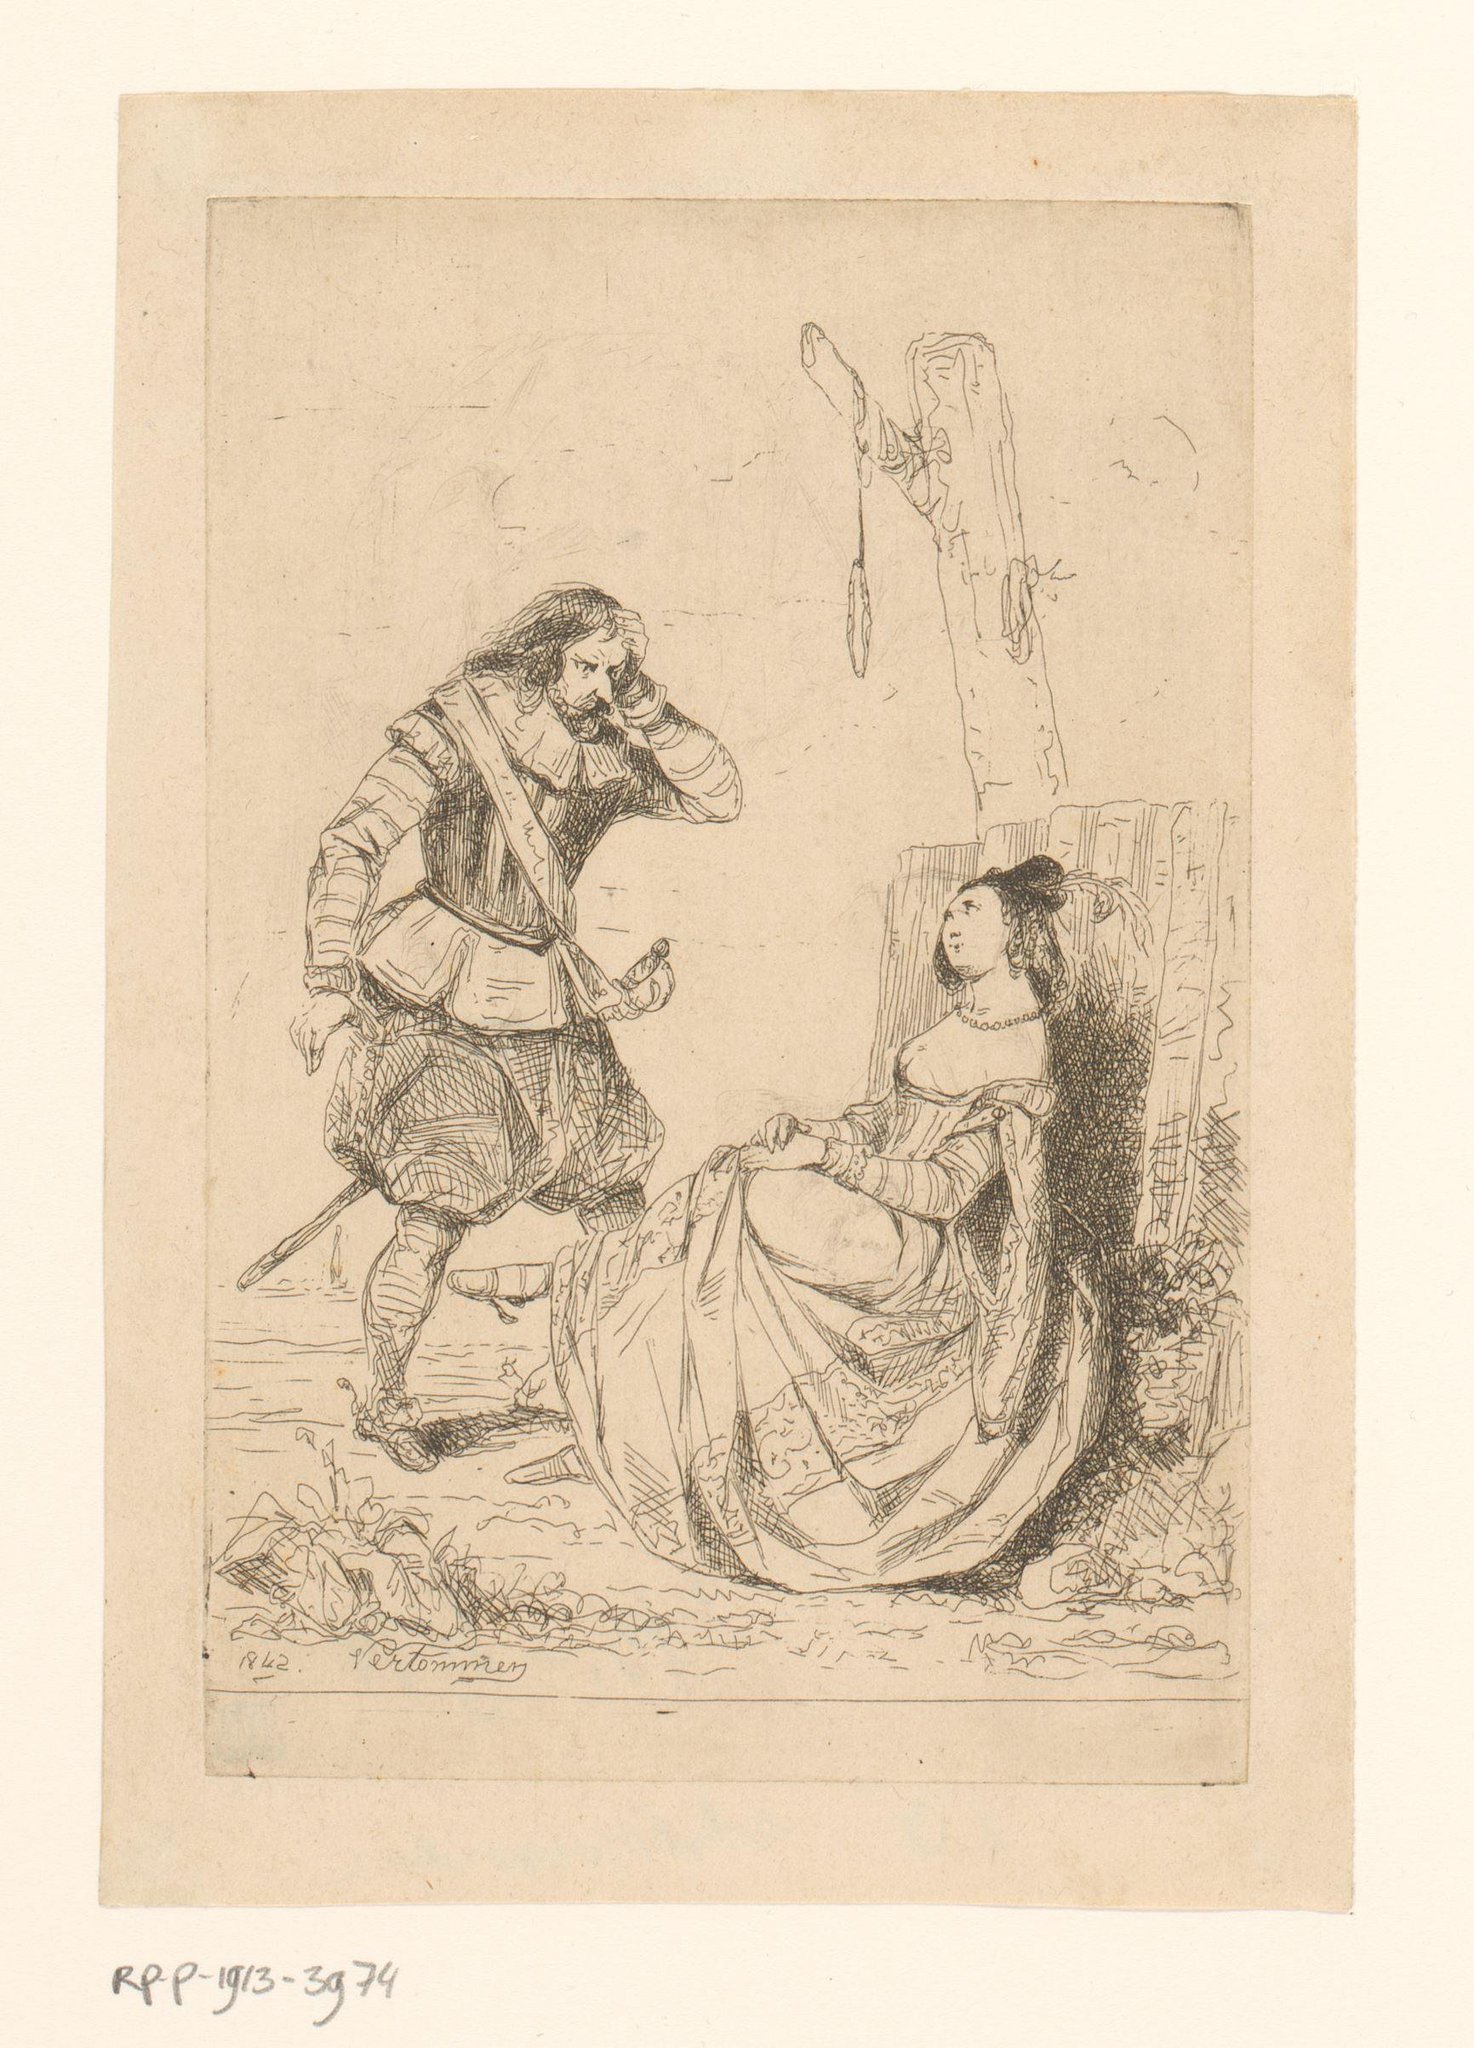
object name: print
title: Krijgsman staat bij een vrouw gezeten onder een galg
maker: guillaume joseph vertommen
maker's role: print maker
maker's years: 1815-1863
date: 1842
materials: paper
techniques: etching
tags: instruments of torture, execution or punishment: gallows, adult woman, adult man, the soldier; the soldier's life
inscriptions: collector's mark: Lugt 1485, collector's mark: Lugt 2228